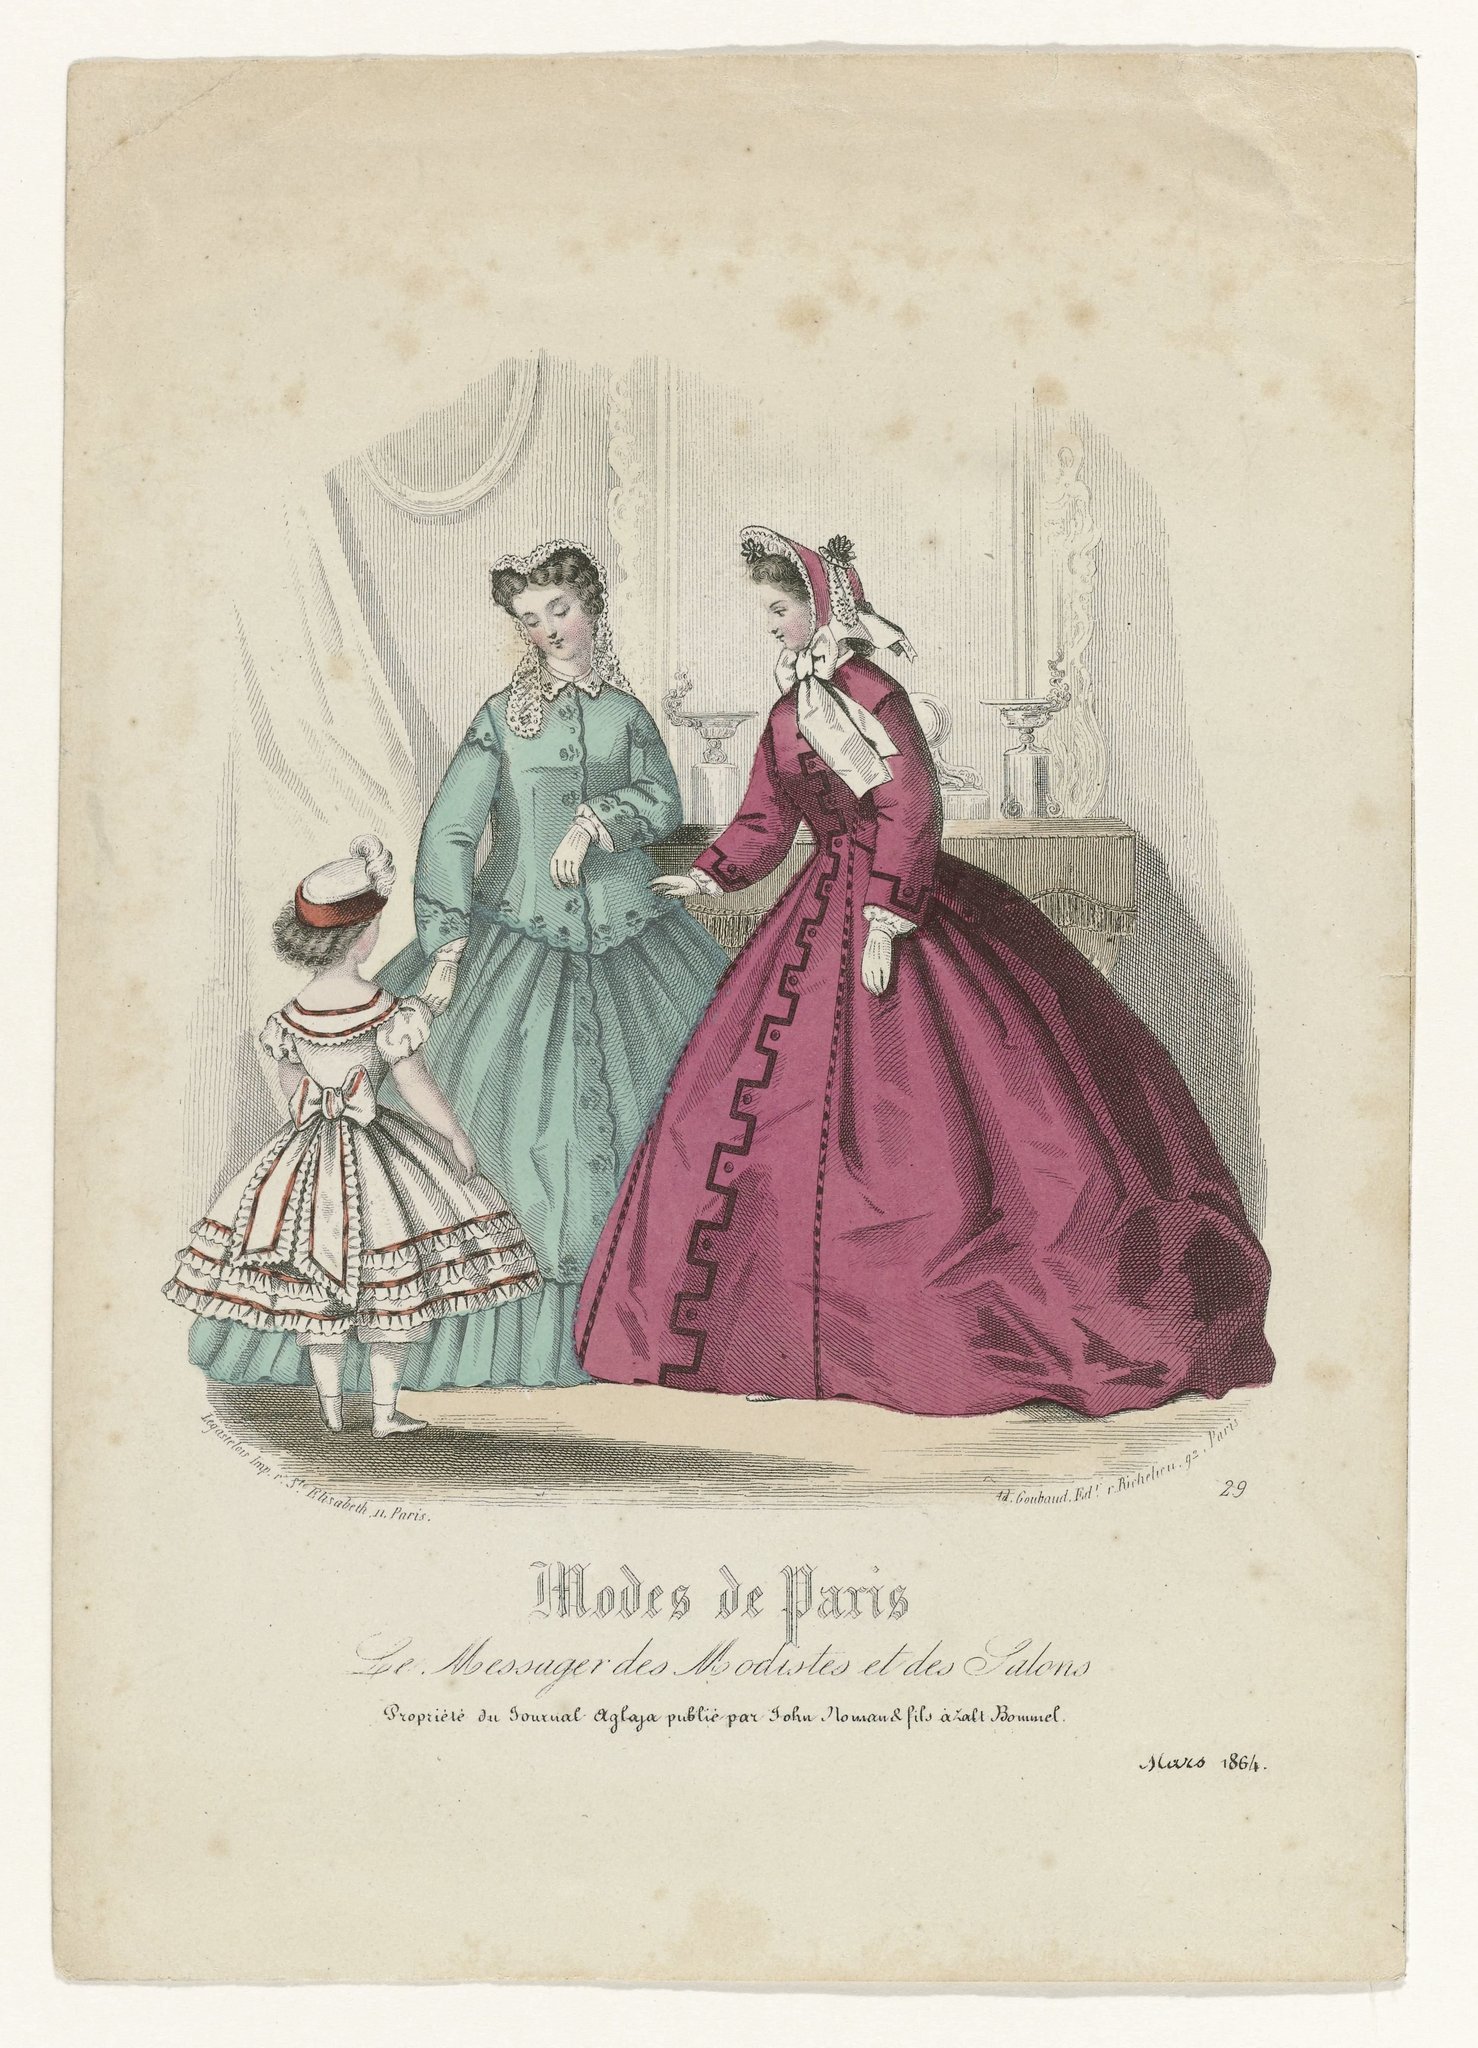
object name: fashion print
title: Le Messager des Modistes et des Salons, Modes de Paris, Journal Aglaja, mars 1864, No. 29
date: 1864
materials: paper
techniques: engraving, hand coloring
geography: paris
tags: clothing for the upper part of the body (+ women's clothes), head-gear: hat (+ girls' clothes), skirt (crinoline skirt) (+ women's clothes), fashion plates, dress, gown (+ girls' clothes)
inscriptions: caption: ‘Propriété du Journal Aglaja publié par John Noman & fils à Zalt Bommel.’, title: ‘Modes de Paris / Le Messager des Modistes et des Salons.’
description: Twee vrouwen in japonnen met wijde rokken. Kinderkleding: meisje in japon met korte pofmouwen en strik op de rug. Randloos hoedje met veer. De prent werd opgenomen in Aglaja (1848-1864), maandboekje voor dames handwerken, uitgegeven door A. C. Kruseman te Haarlem.